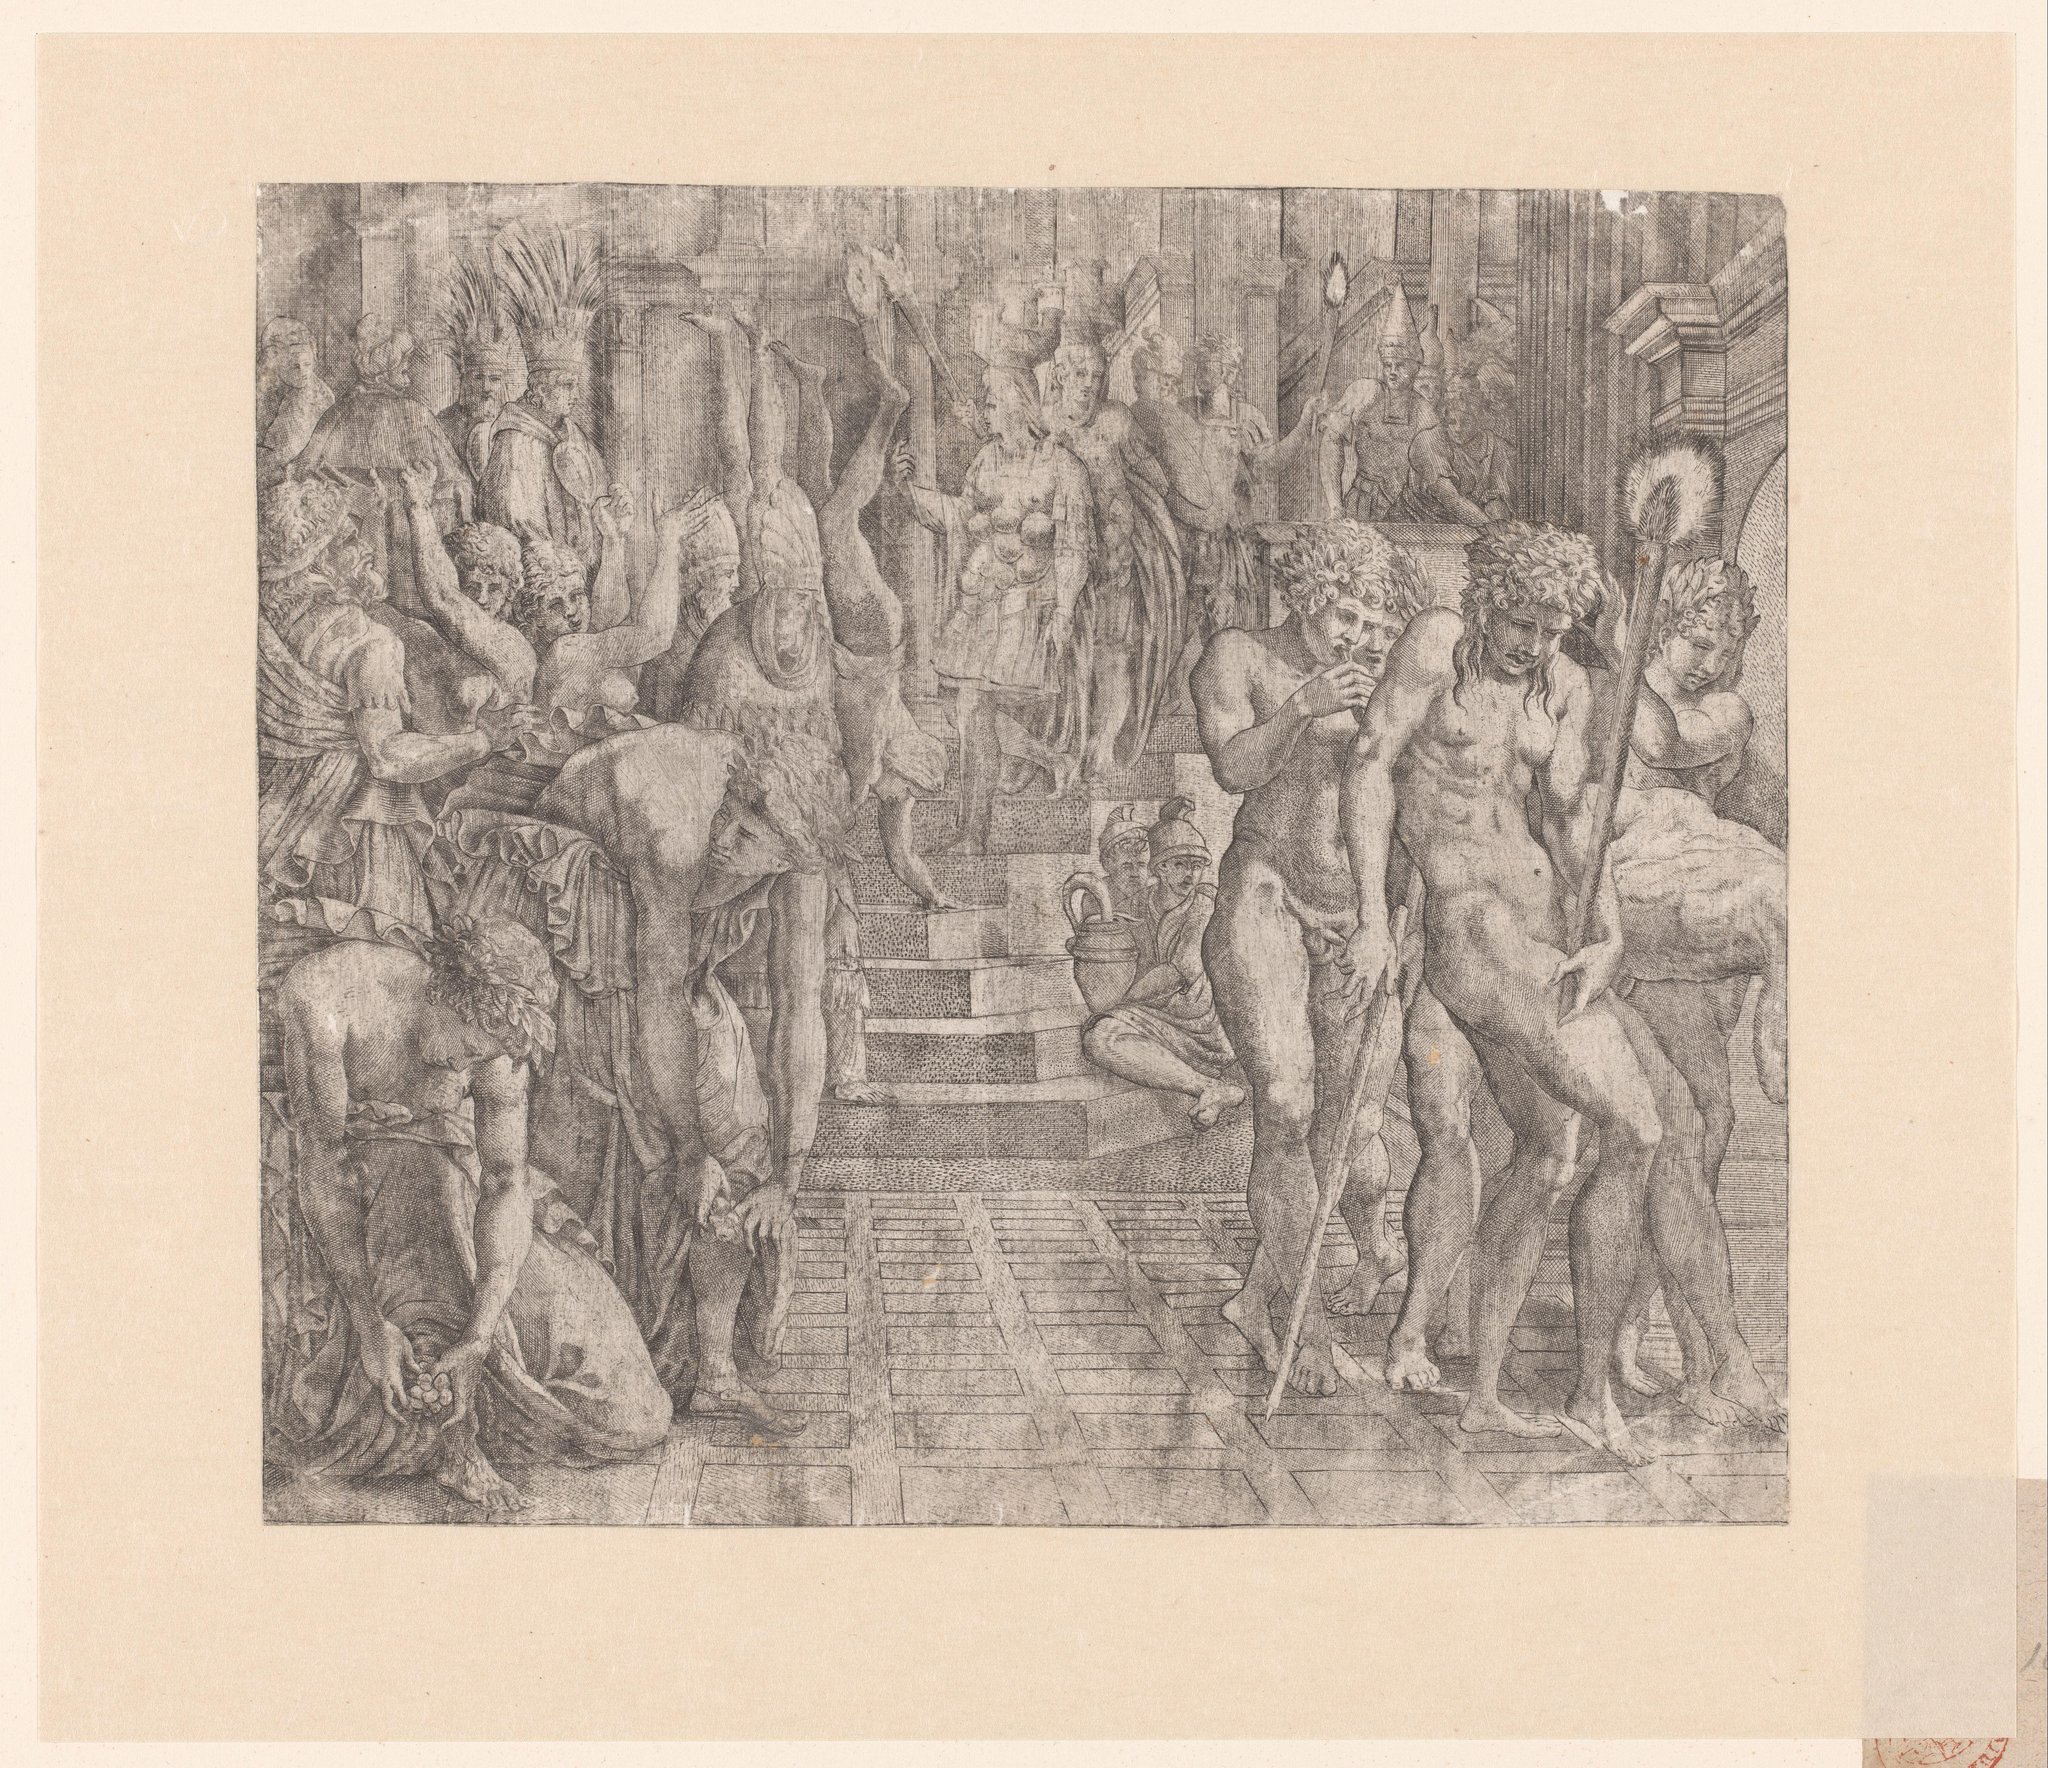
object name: print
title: Alexander de Grote steekt Persepolis in de brand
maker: jean chartier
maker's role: print maker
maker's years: 1500-1580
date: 1514-1580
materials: paper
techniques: engraving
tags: in a fit of intoxication at a feast, and encouraged by the courtesan thais, alexander sets persepolis on fire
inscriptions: collector's mark: Lugt 240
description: Het werk door Primaticcio dat deel uitmaakt van een reeks over het leven van Alexander de Grote wordt verloren gewaand. Een voorbereidende tekening bevindt zich in de collectie van het Musée du Louvre te Parijs, inv.nr. 8568 recto.